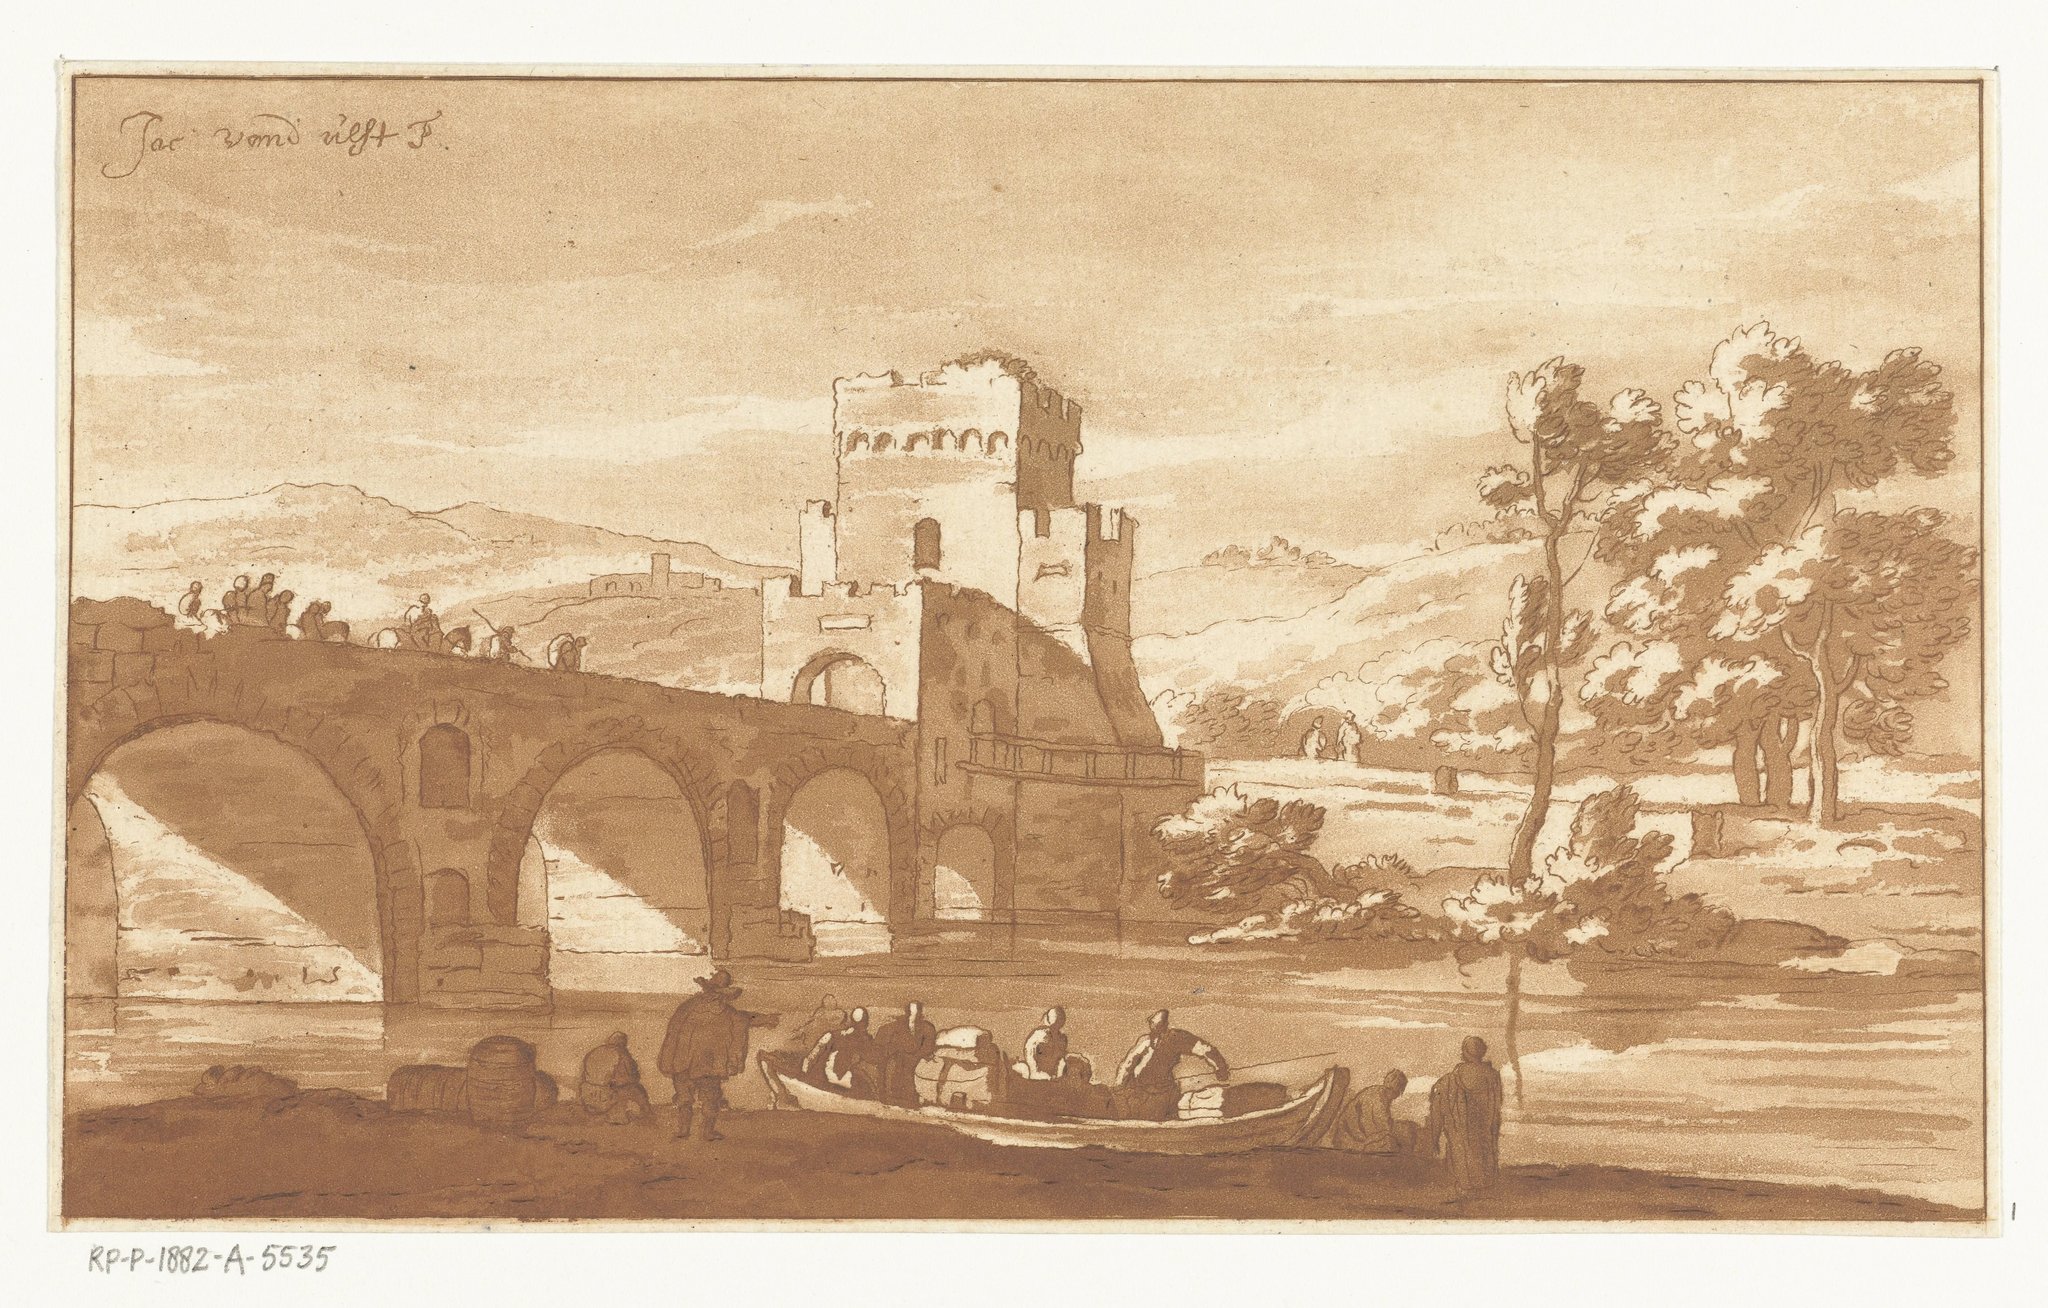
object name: print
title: Ponte Molle bij Rome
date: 1741-1803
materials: paper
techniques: aquatint, etching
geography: netherlands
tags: landscape with bridge, viaduct or aqueduct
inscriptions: collector's mark: Lugt 2228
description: Prent naar tekening van Jacob van der Ulft gedrukt met twee platen. Prent uit serie van negen prenttekeningen met acht landschappen en een zeegezicht naar Hollandse meesters uit de 17e eeuw, zie Huffel 1921, p. 33-35. De originele tekening van Jacob van der Ulft bevindt zich in de collectie van Fondation Custodia te Parijs.